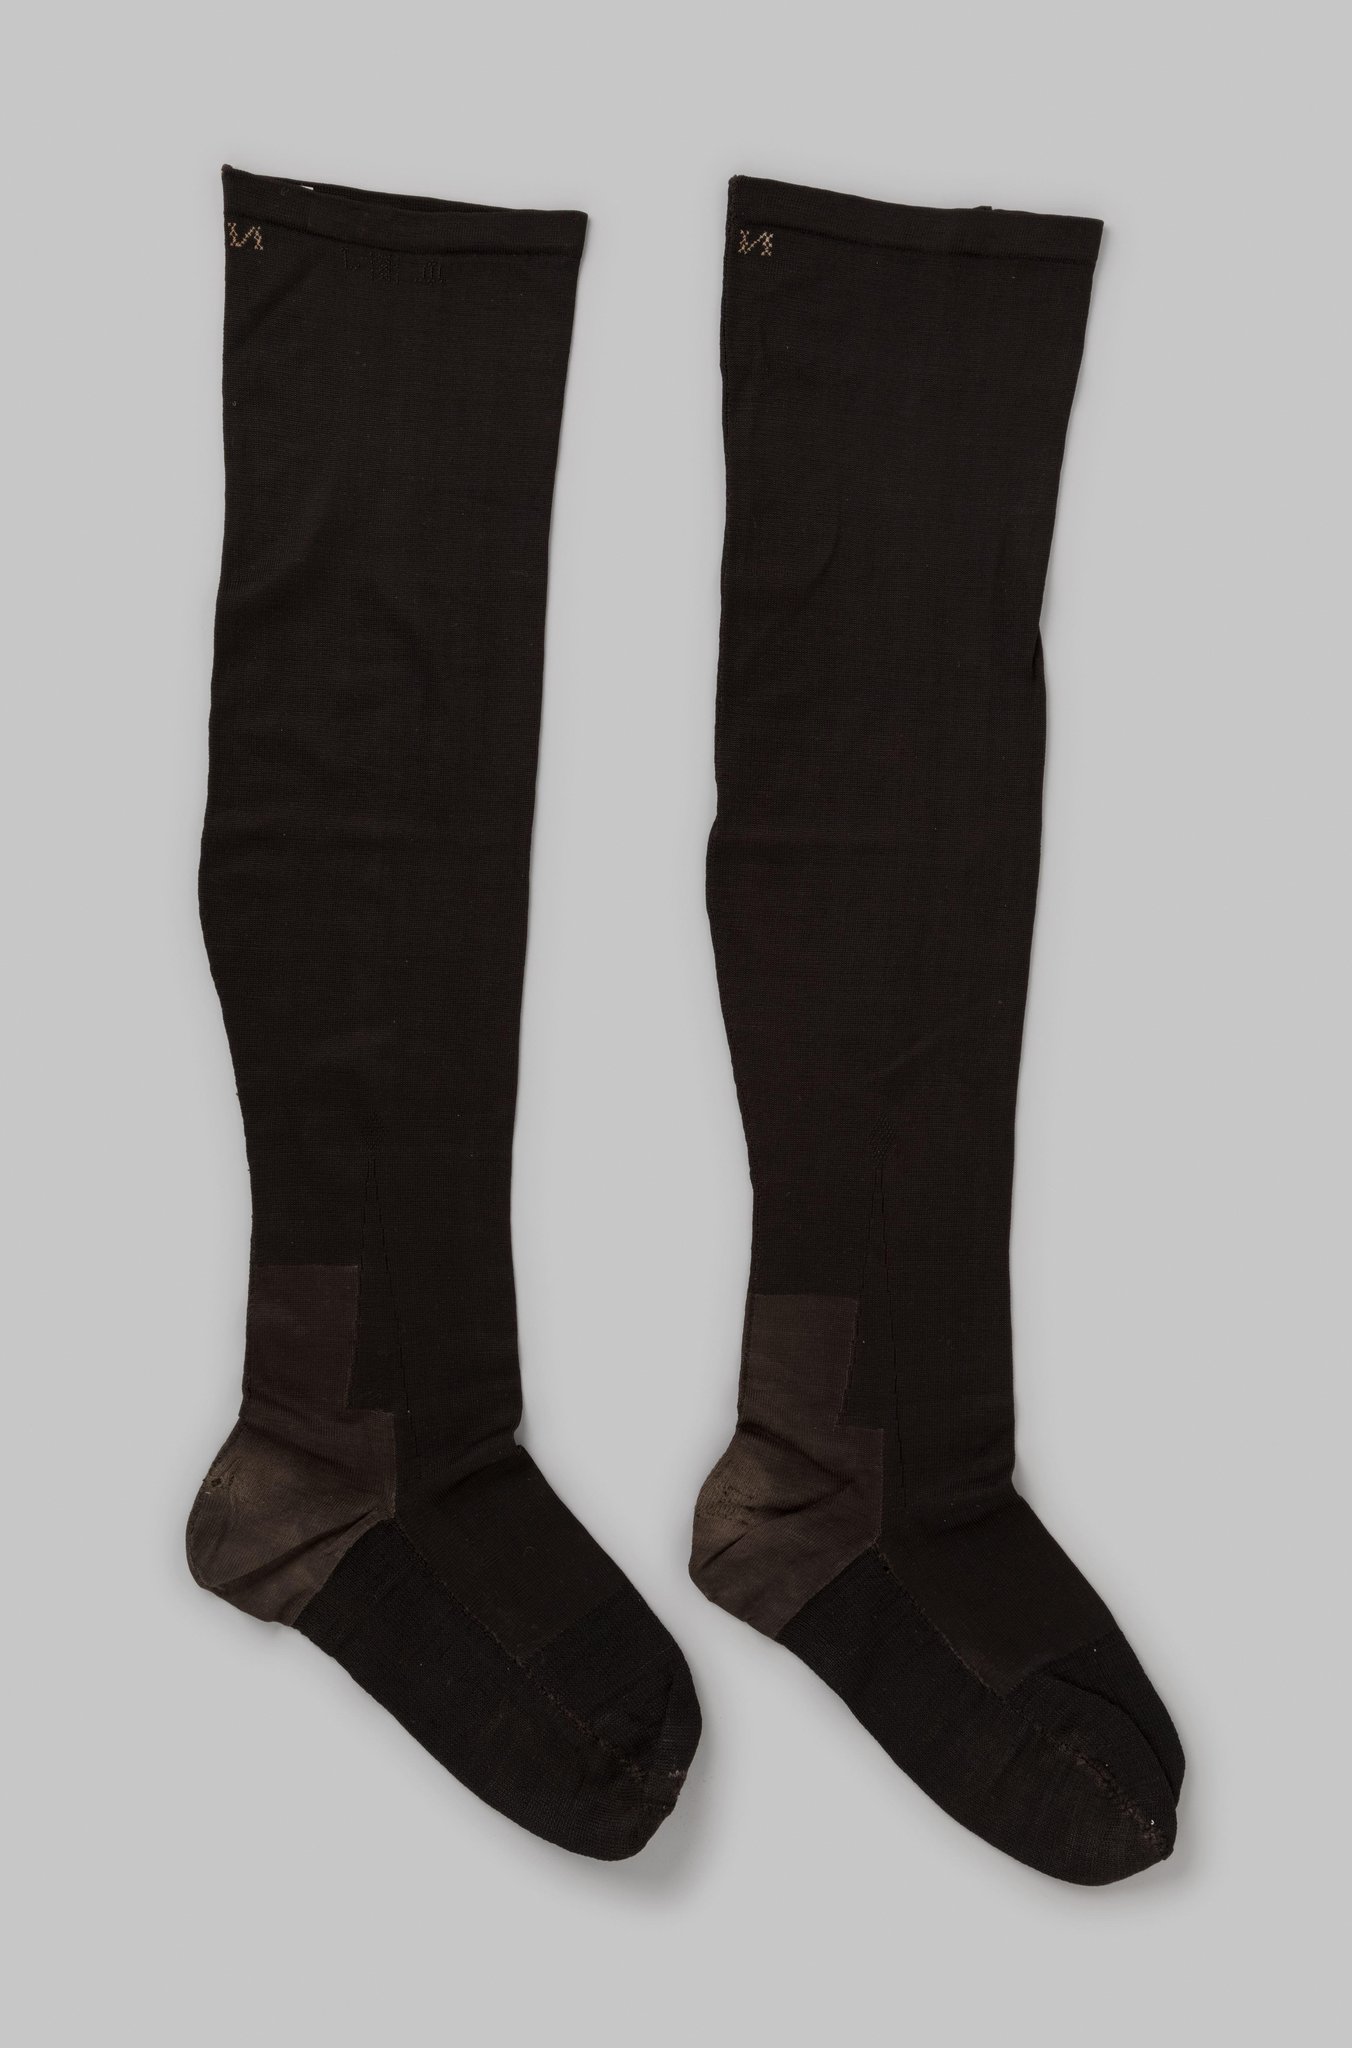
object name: stocking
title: Kous gebreid van effen zwarte glanzend katoen, met voetstukken van wol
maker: Anonymous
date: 1800-1820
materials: cotton, wool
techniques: cross stitching, embroidered, knitting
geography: netherlands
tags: vught, minister, staatsman, intendant-generaal van financien, secretaris van staat voor financien, minister van financiën, izaak jean alexandre gogel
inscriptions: initials: ‘N’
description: Kous gebreid van effen zwarte glanzend katoen, met voetstukken van wol. Naad middenachter, geborduurde diamantvorm op de klink. Smalle boord. In ecrukleurig kruissteek de letter 'N'.